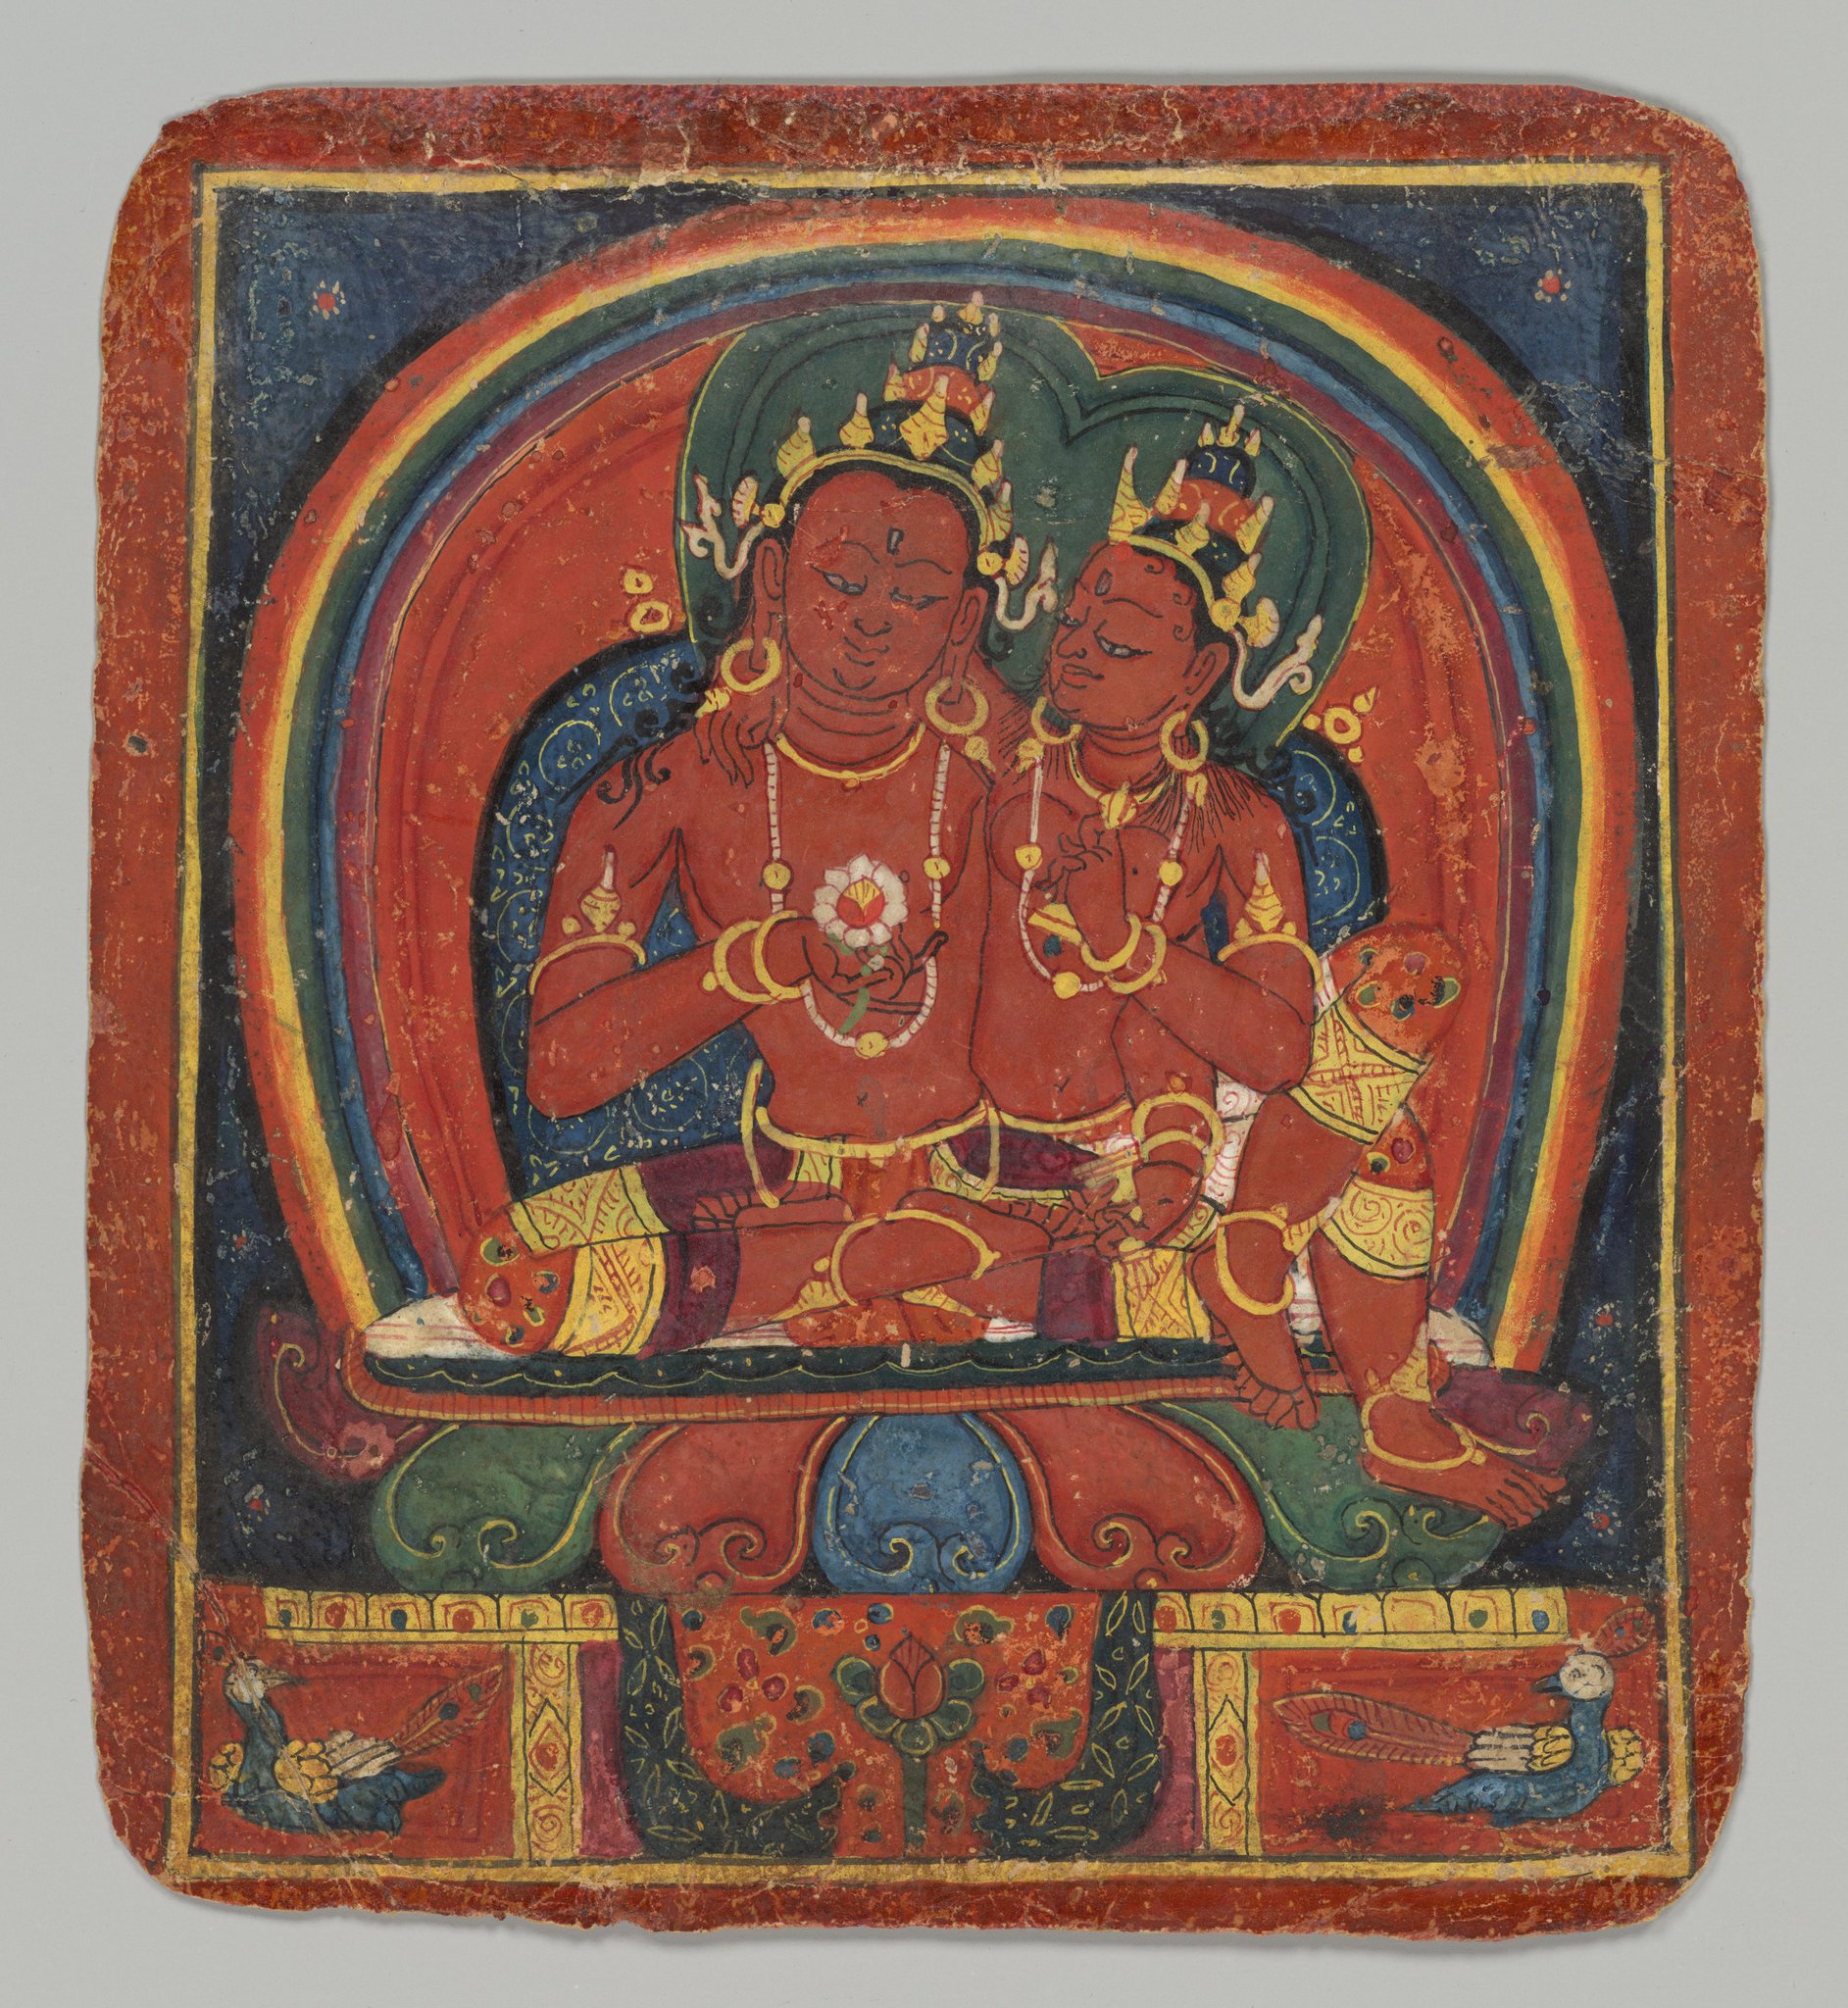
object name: initiation card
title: Initiation Card (Tsakalis): Amitabha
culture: tibetan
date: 1401-1433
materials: paper, watercolor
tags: buddhism,deities